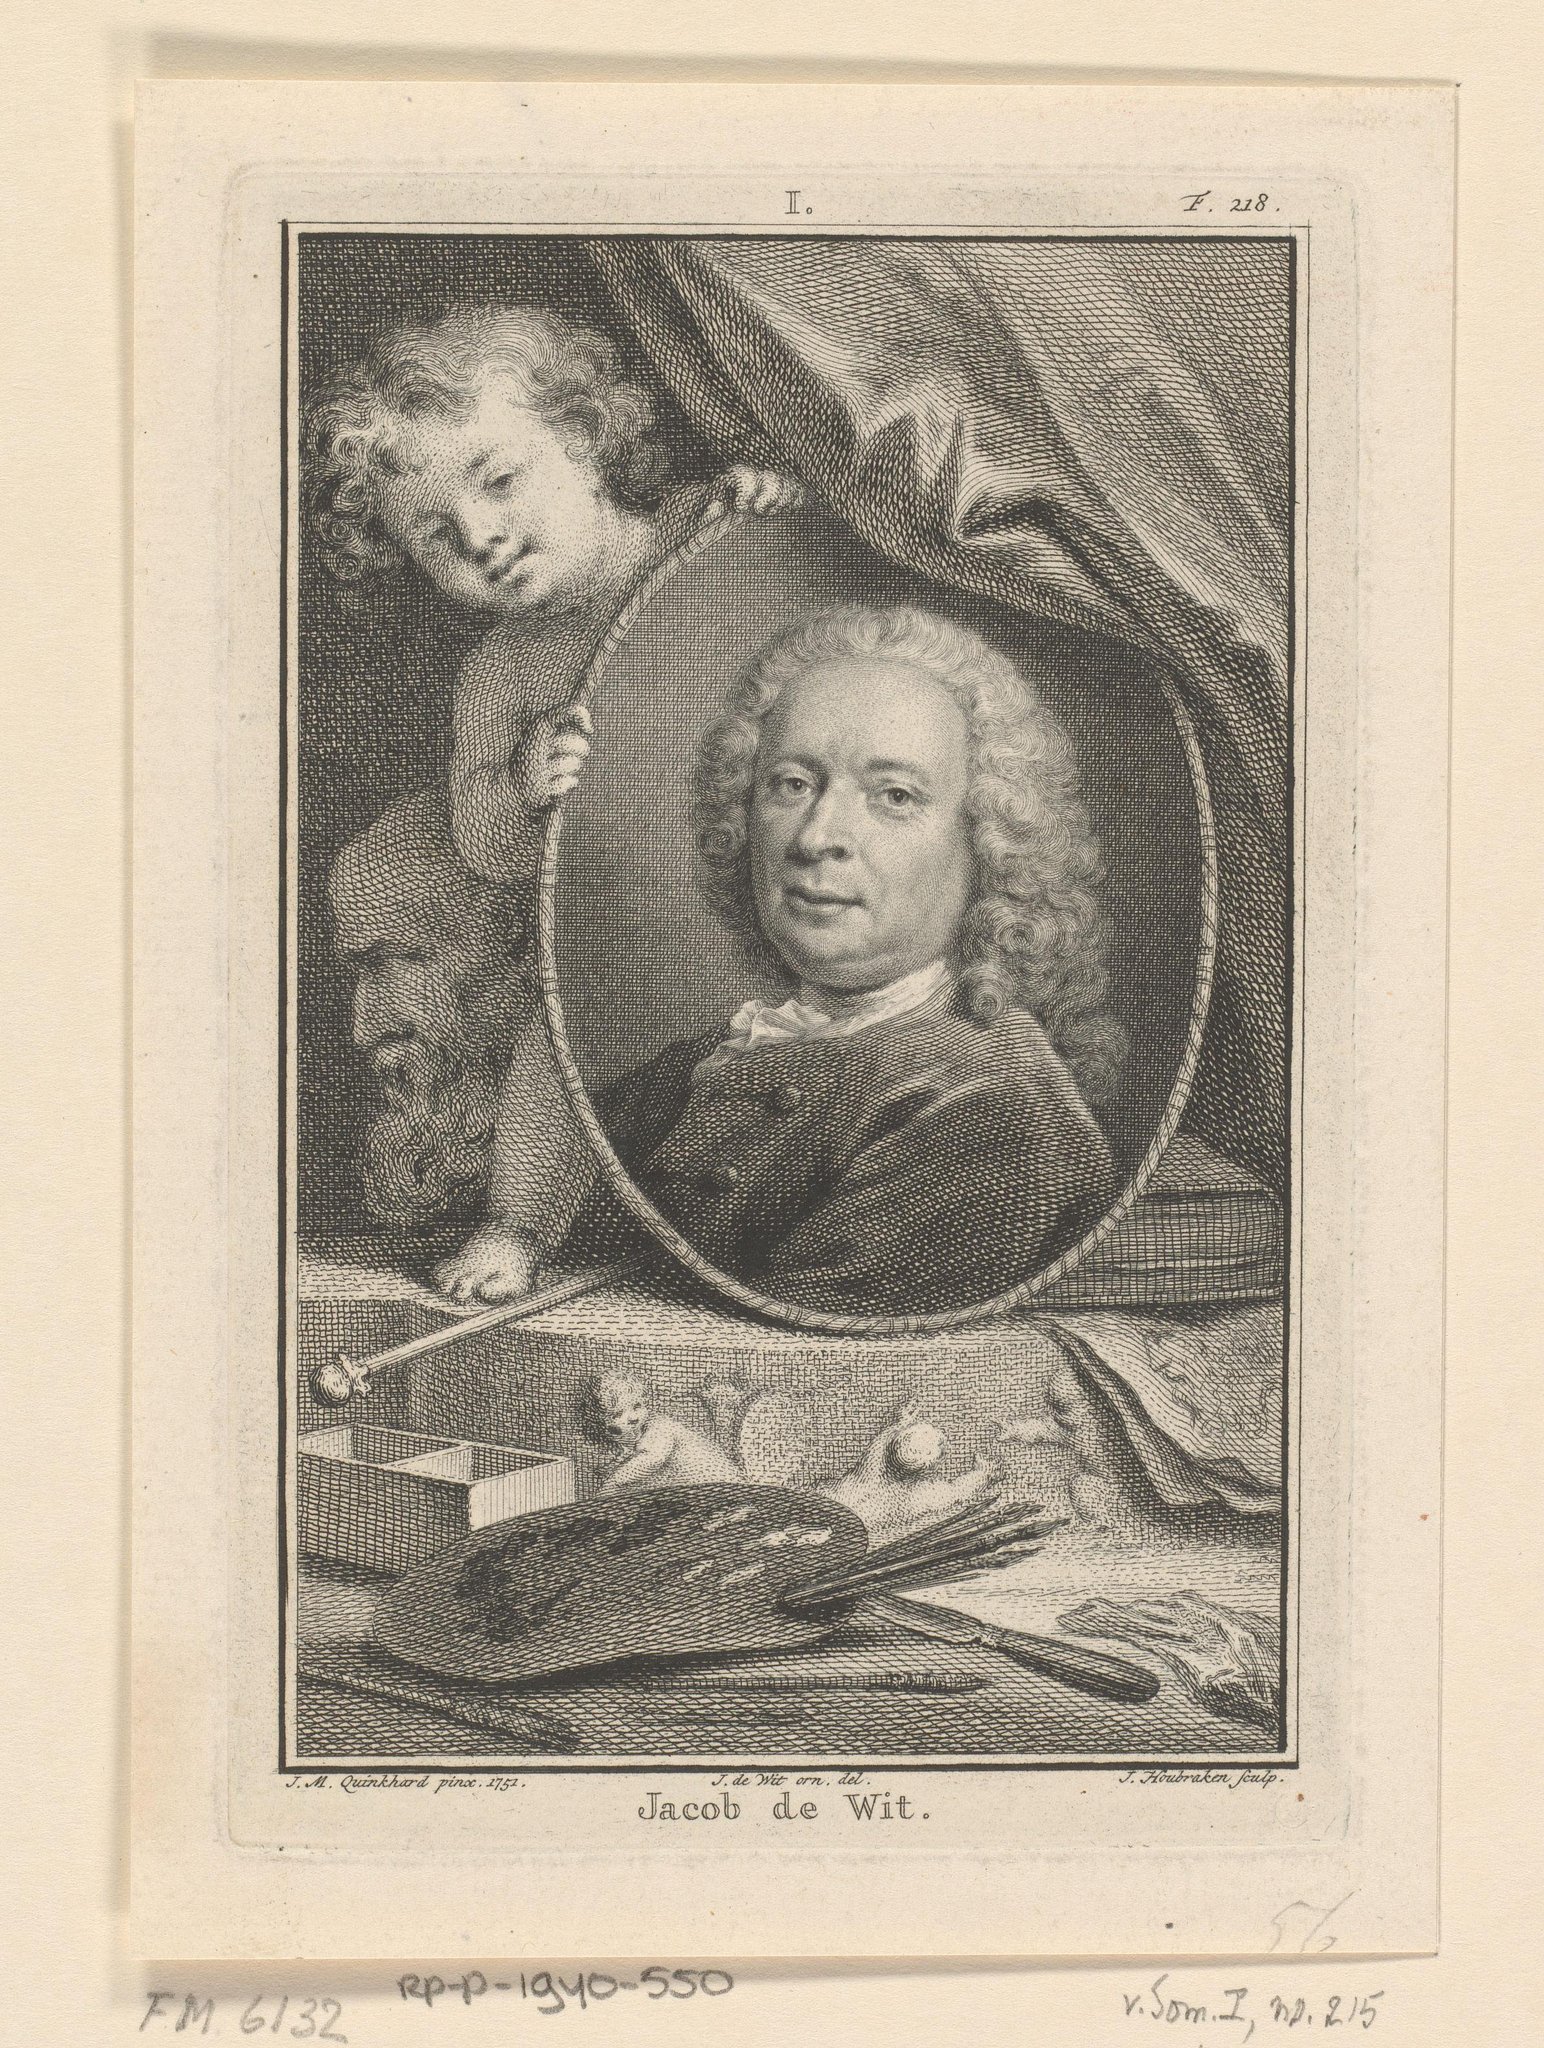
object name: book illustration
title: Portret van Jacob de Wit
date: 1751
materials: paper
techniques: engraving, etching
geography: amsterdam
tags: painter, print maker, draughtsman, jacob de wit, historical persons, portrait, self-portrait of painter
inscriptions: collector's mark: Lugt 2760, number: ‘56’, collector's mark: Lugt 2228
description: Prent waarschijnlijk uit: Gool, Johan van. De nieuwe schouburg der Nederlantsche kunstschilders en schilderessen: (...). Den Haag: Johan van Gool, 1751, dl. 2, p. 218.